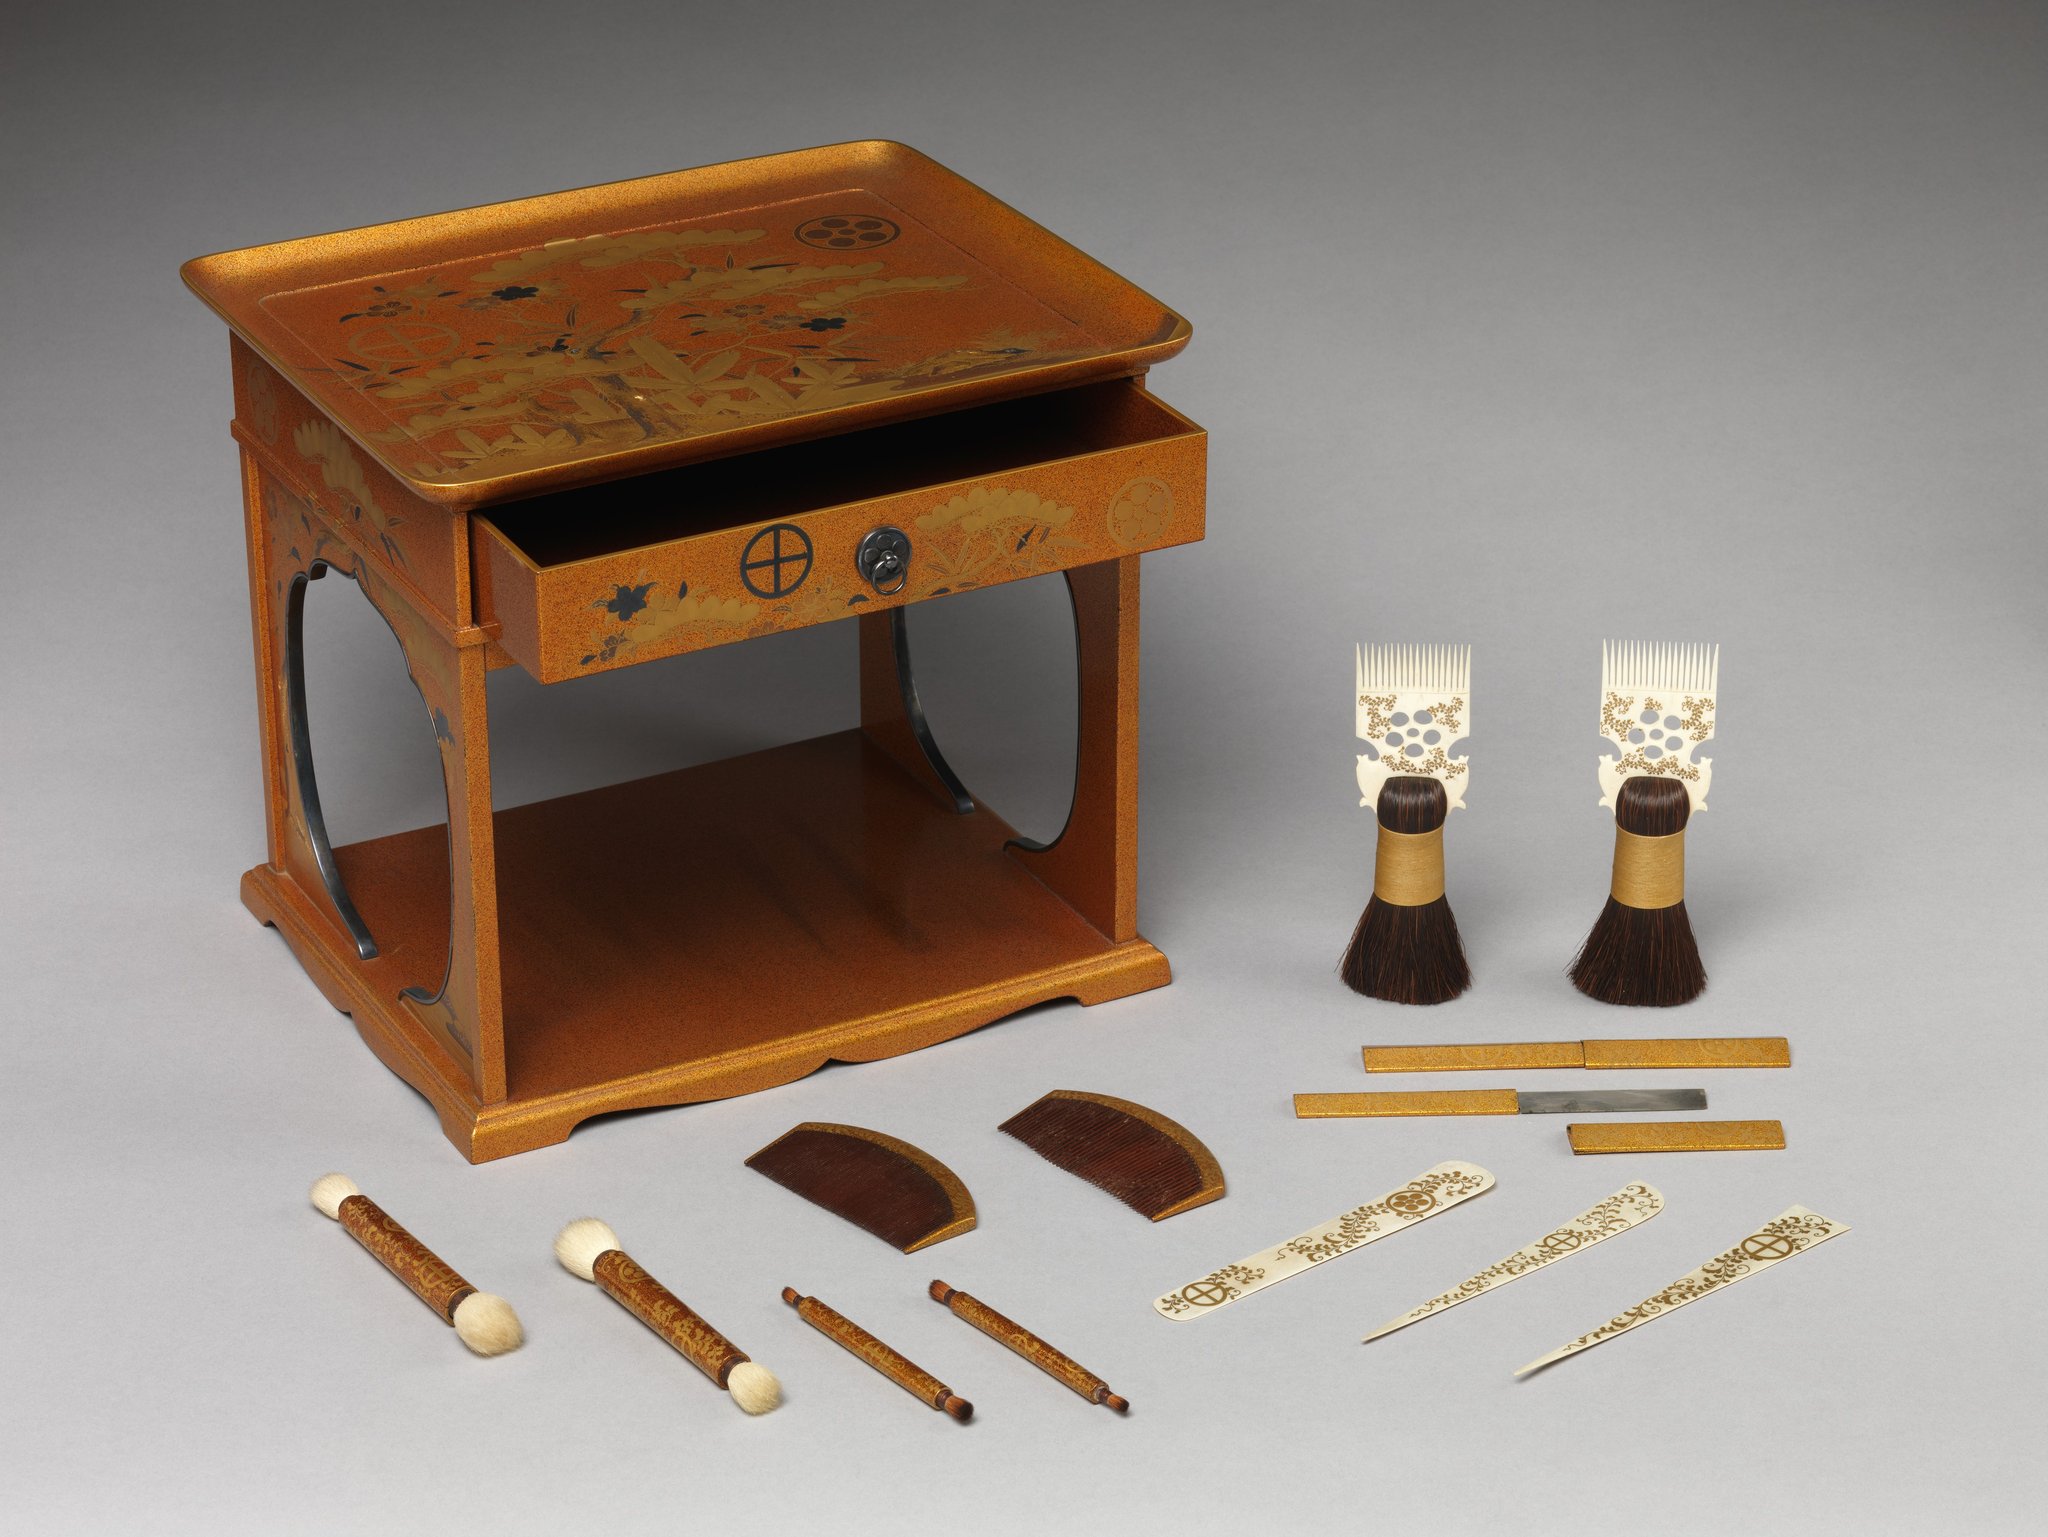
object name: cosmetic stand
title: Cosmetic Stand with Pine, Bamboo, and Cherry Blossom from a Wedding Set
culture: japanese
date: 1801-1833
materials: gold, gold foil, silver, wood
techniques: cutting, hiramakie, lacquer, maki-e